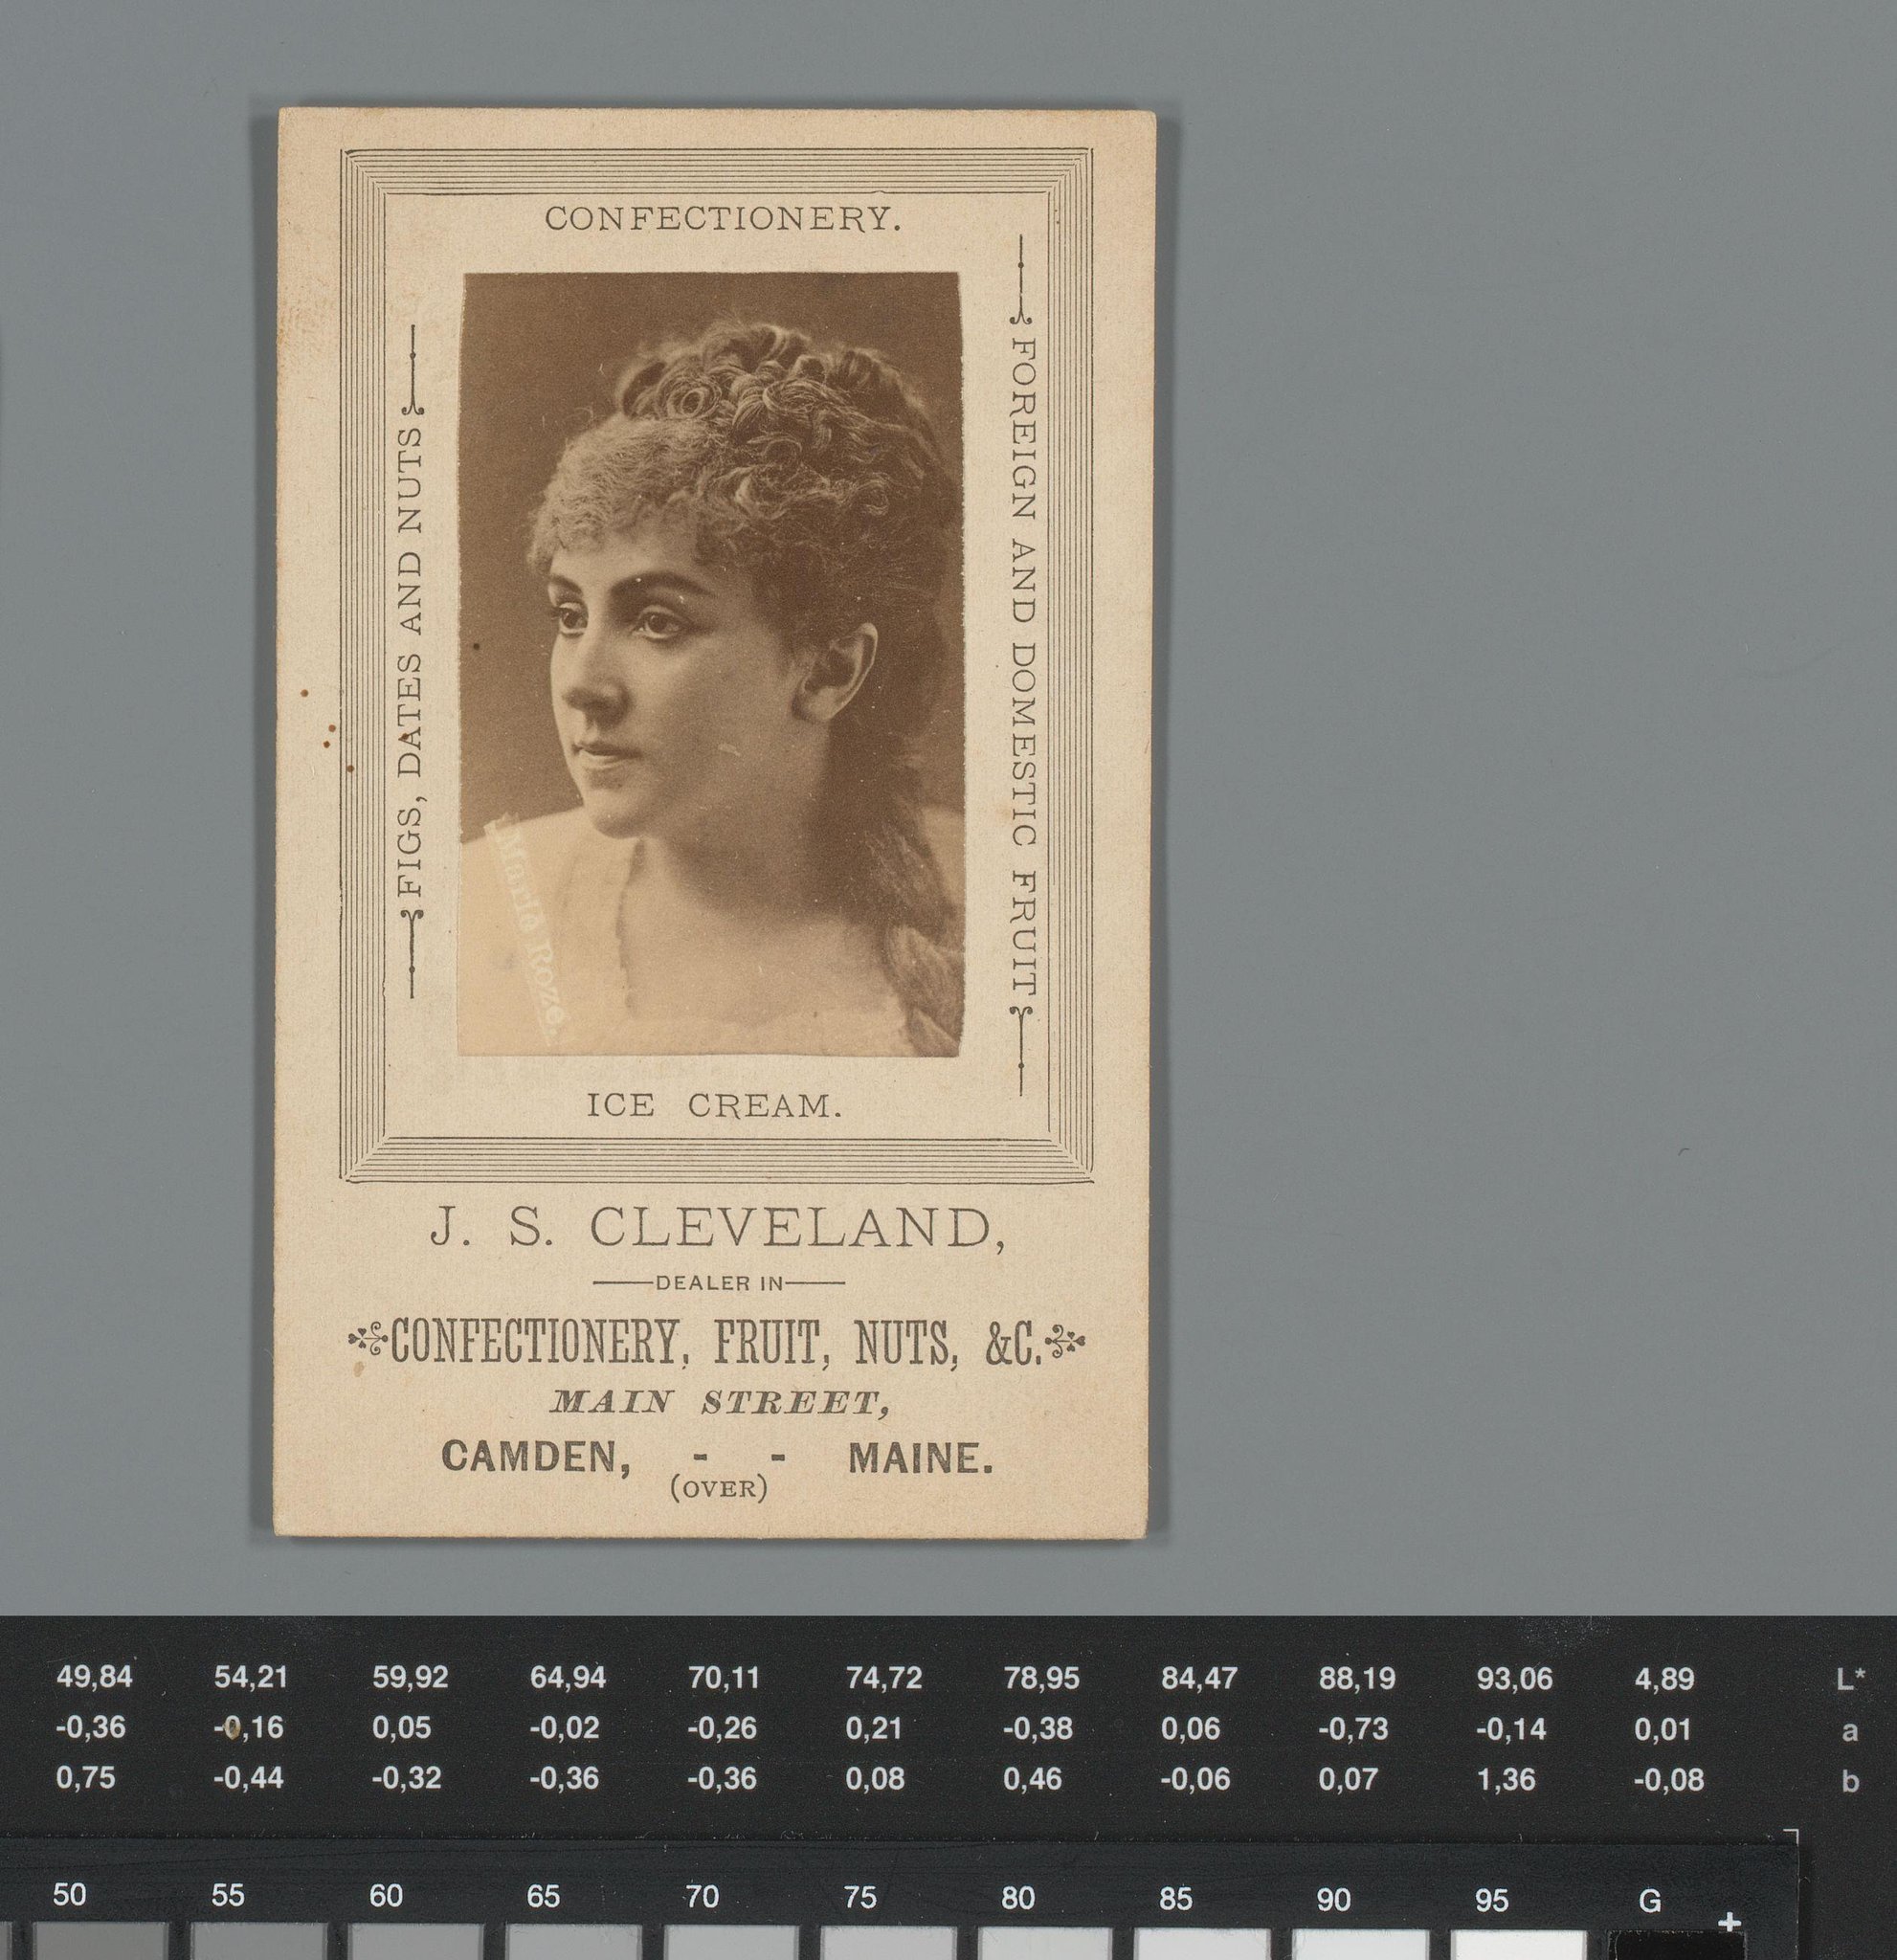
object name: photograph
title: Reclame voor de handel van J. S. Cleveland in Camden, Maine, met portret van Marie Roze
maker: Anonymous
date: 1850-1915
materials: cardboard, photographic support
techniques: albumen print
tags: marie roze, advertising, historical persons - bb - woman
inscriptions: inscription: ‘(...)/ H. D. Moulton, Pub., Fitchburg, Mass.’